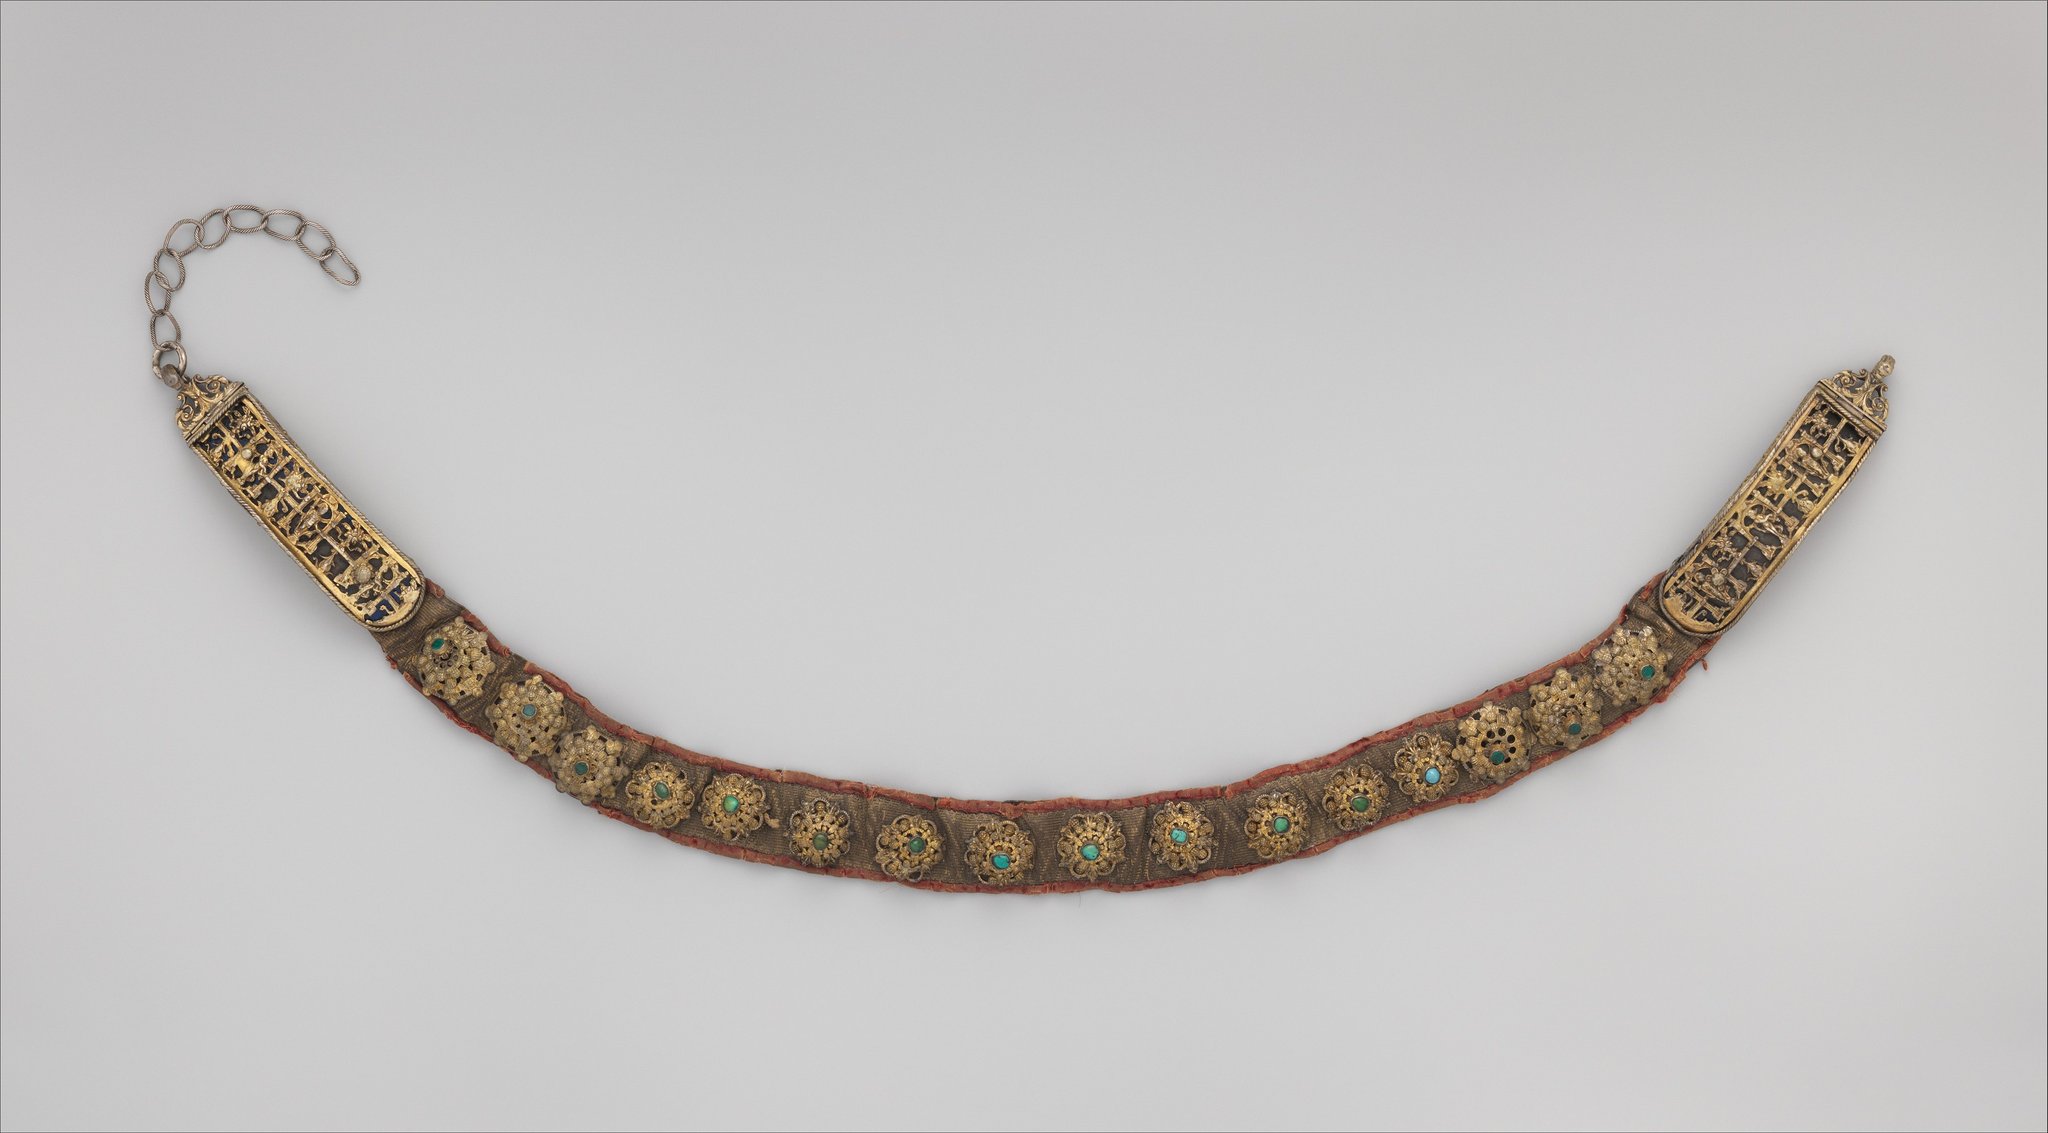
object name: belt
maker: simon henek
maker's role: maker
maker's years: 1609-1629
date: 1601-1633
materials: gilt silver, glass, metal thread, silk, velvet